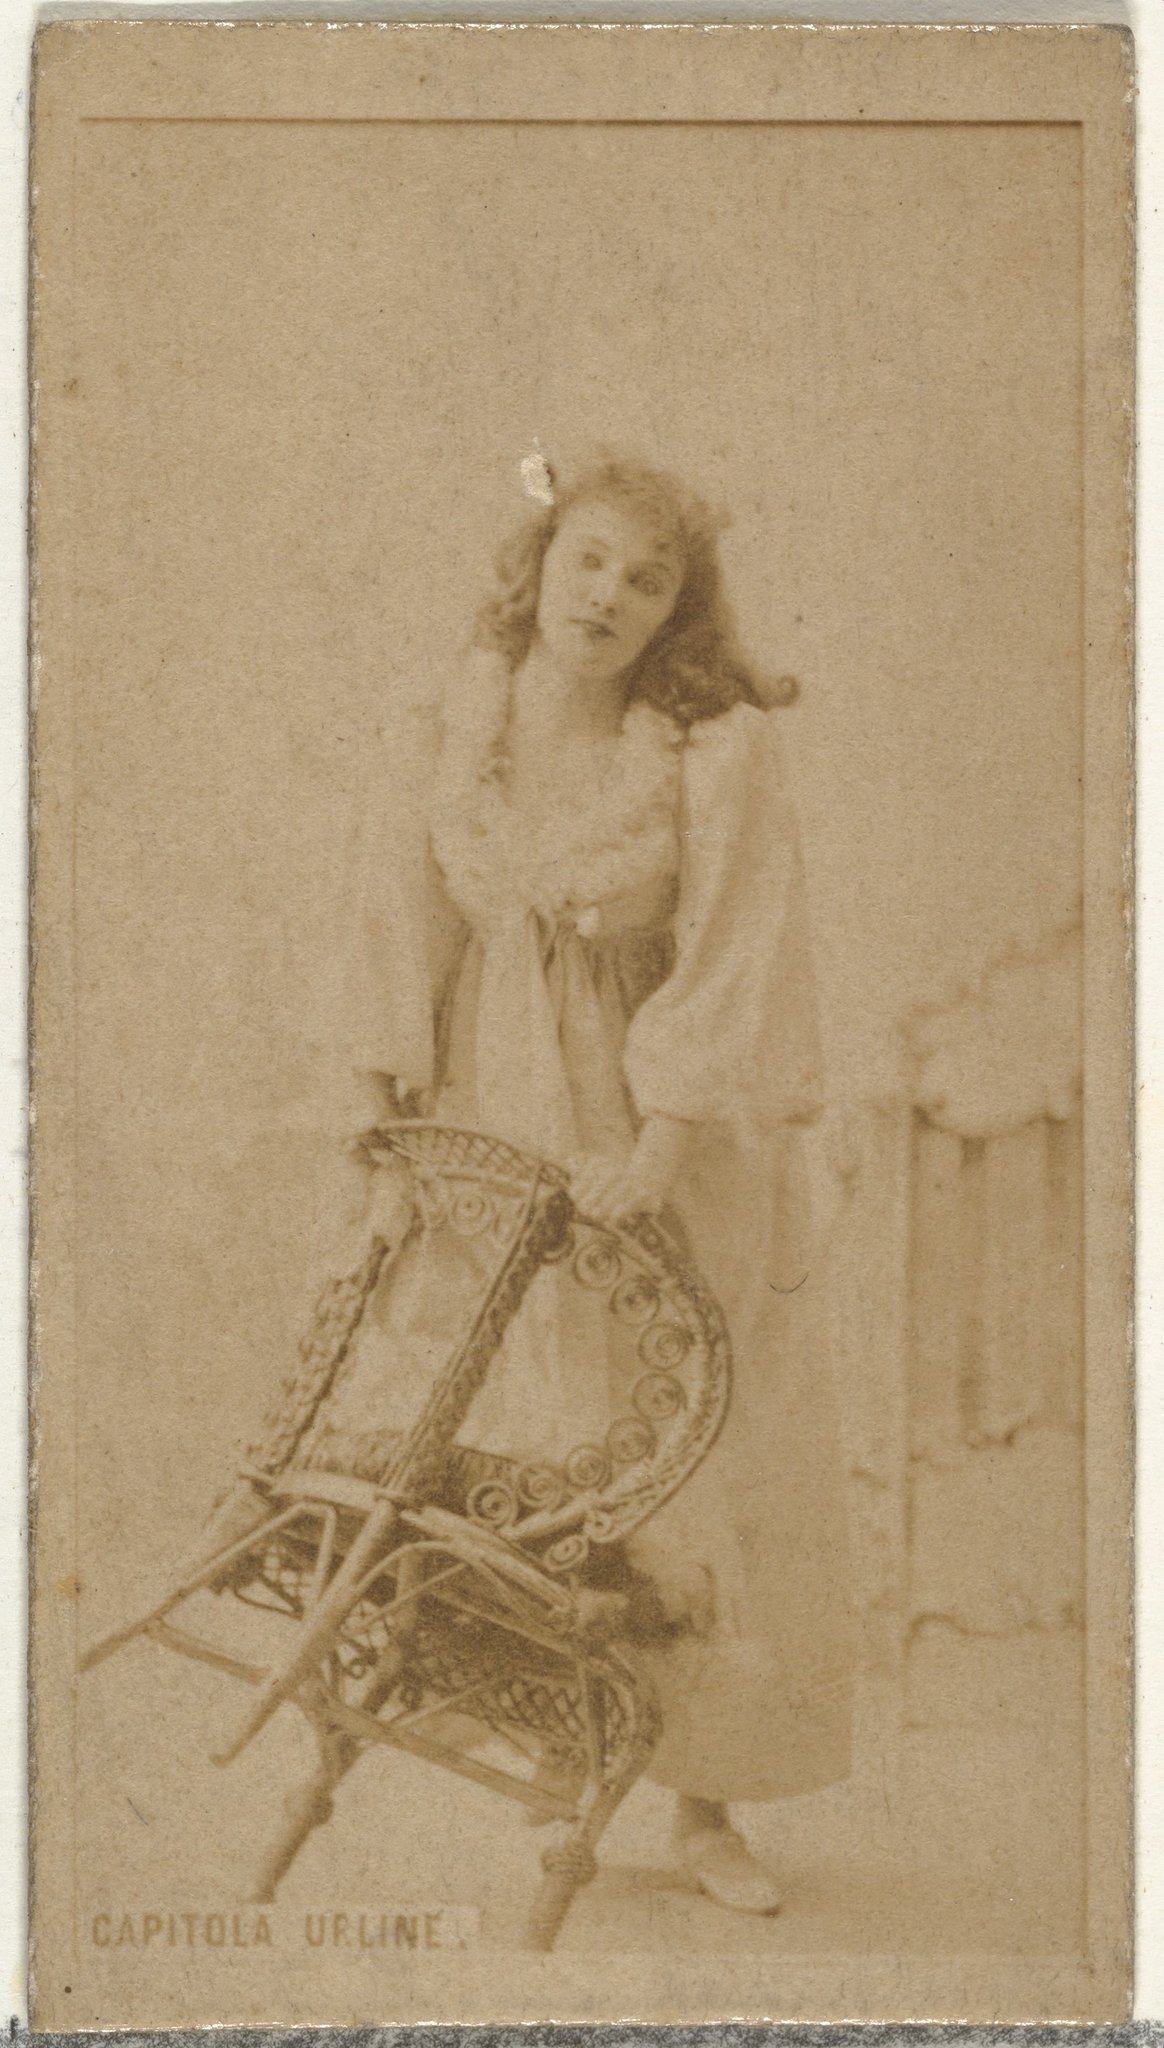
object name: photograph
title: Capitola Urline, from the Actors and Actresses series (N145-8) issued by Duke Sons & Co. to promote Duke Cigarettes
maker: w. duke, sons & co.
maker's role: publisher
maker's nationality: american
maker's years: 1870-1920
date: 1891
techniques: albumen silver print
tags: portraits,women,actresses